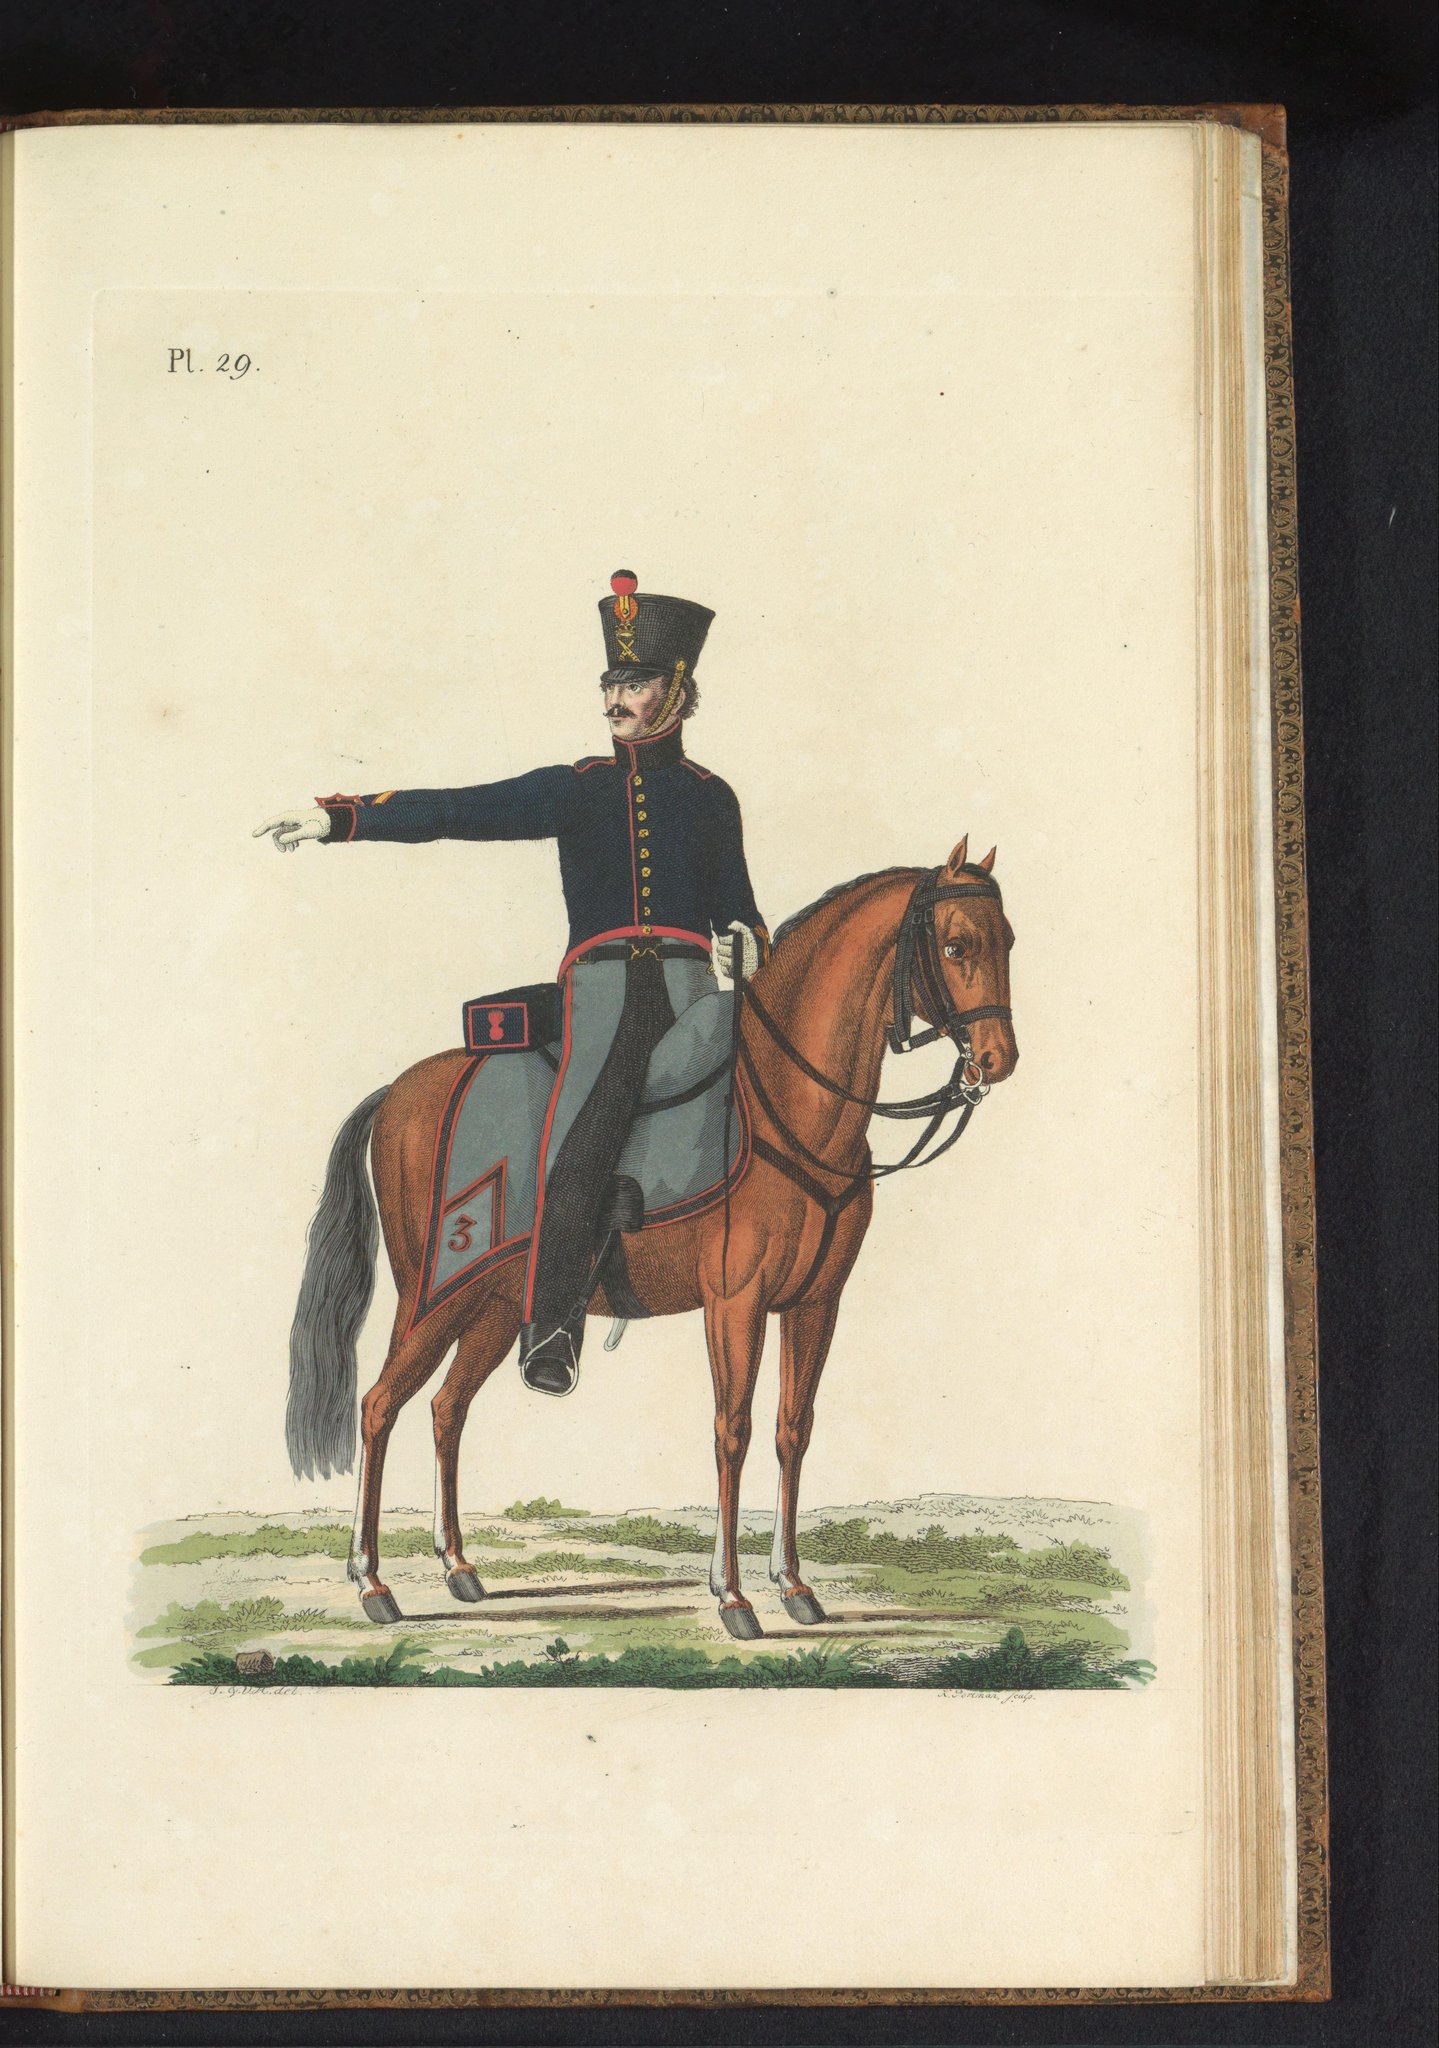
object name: print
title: Wachtmeester, te paard, Artillerie-Trein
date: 1823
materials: paper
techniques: engraving, etching, hand coloring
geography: netherlands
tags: (military) uniforms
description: Een Nederlandse wachtmeester van de artillerie-trein, te paard. Plaat 29. Uniformvoorstelling in 'Beschrijving hoedanig de Koninklijke Nederlandsche troepen' van J.F. Teupken, 1823.